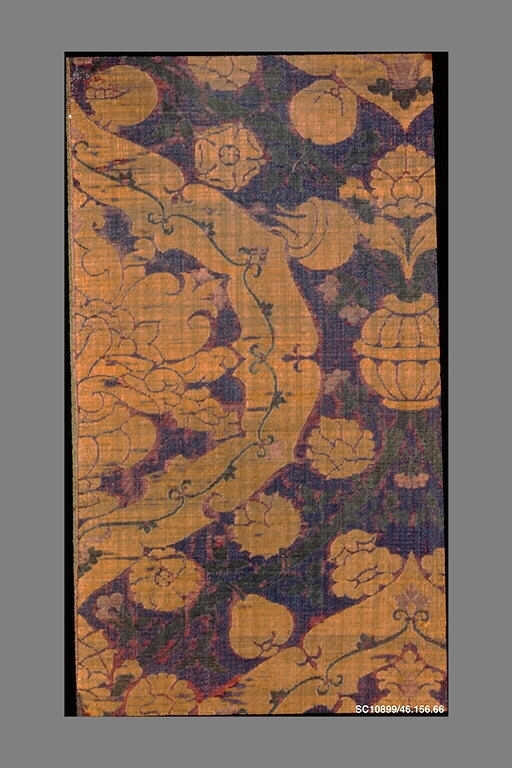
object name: piece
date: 1501-1525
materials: silk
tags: flowers